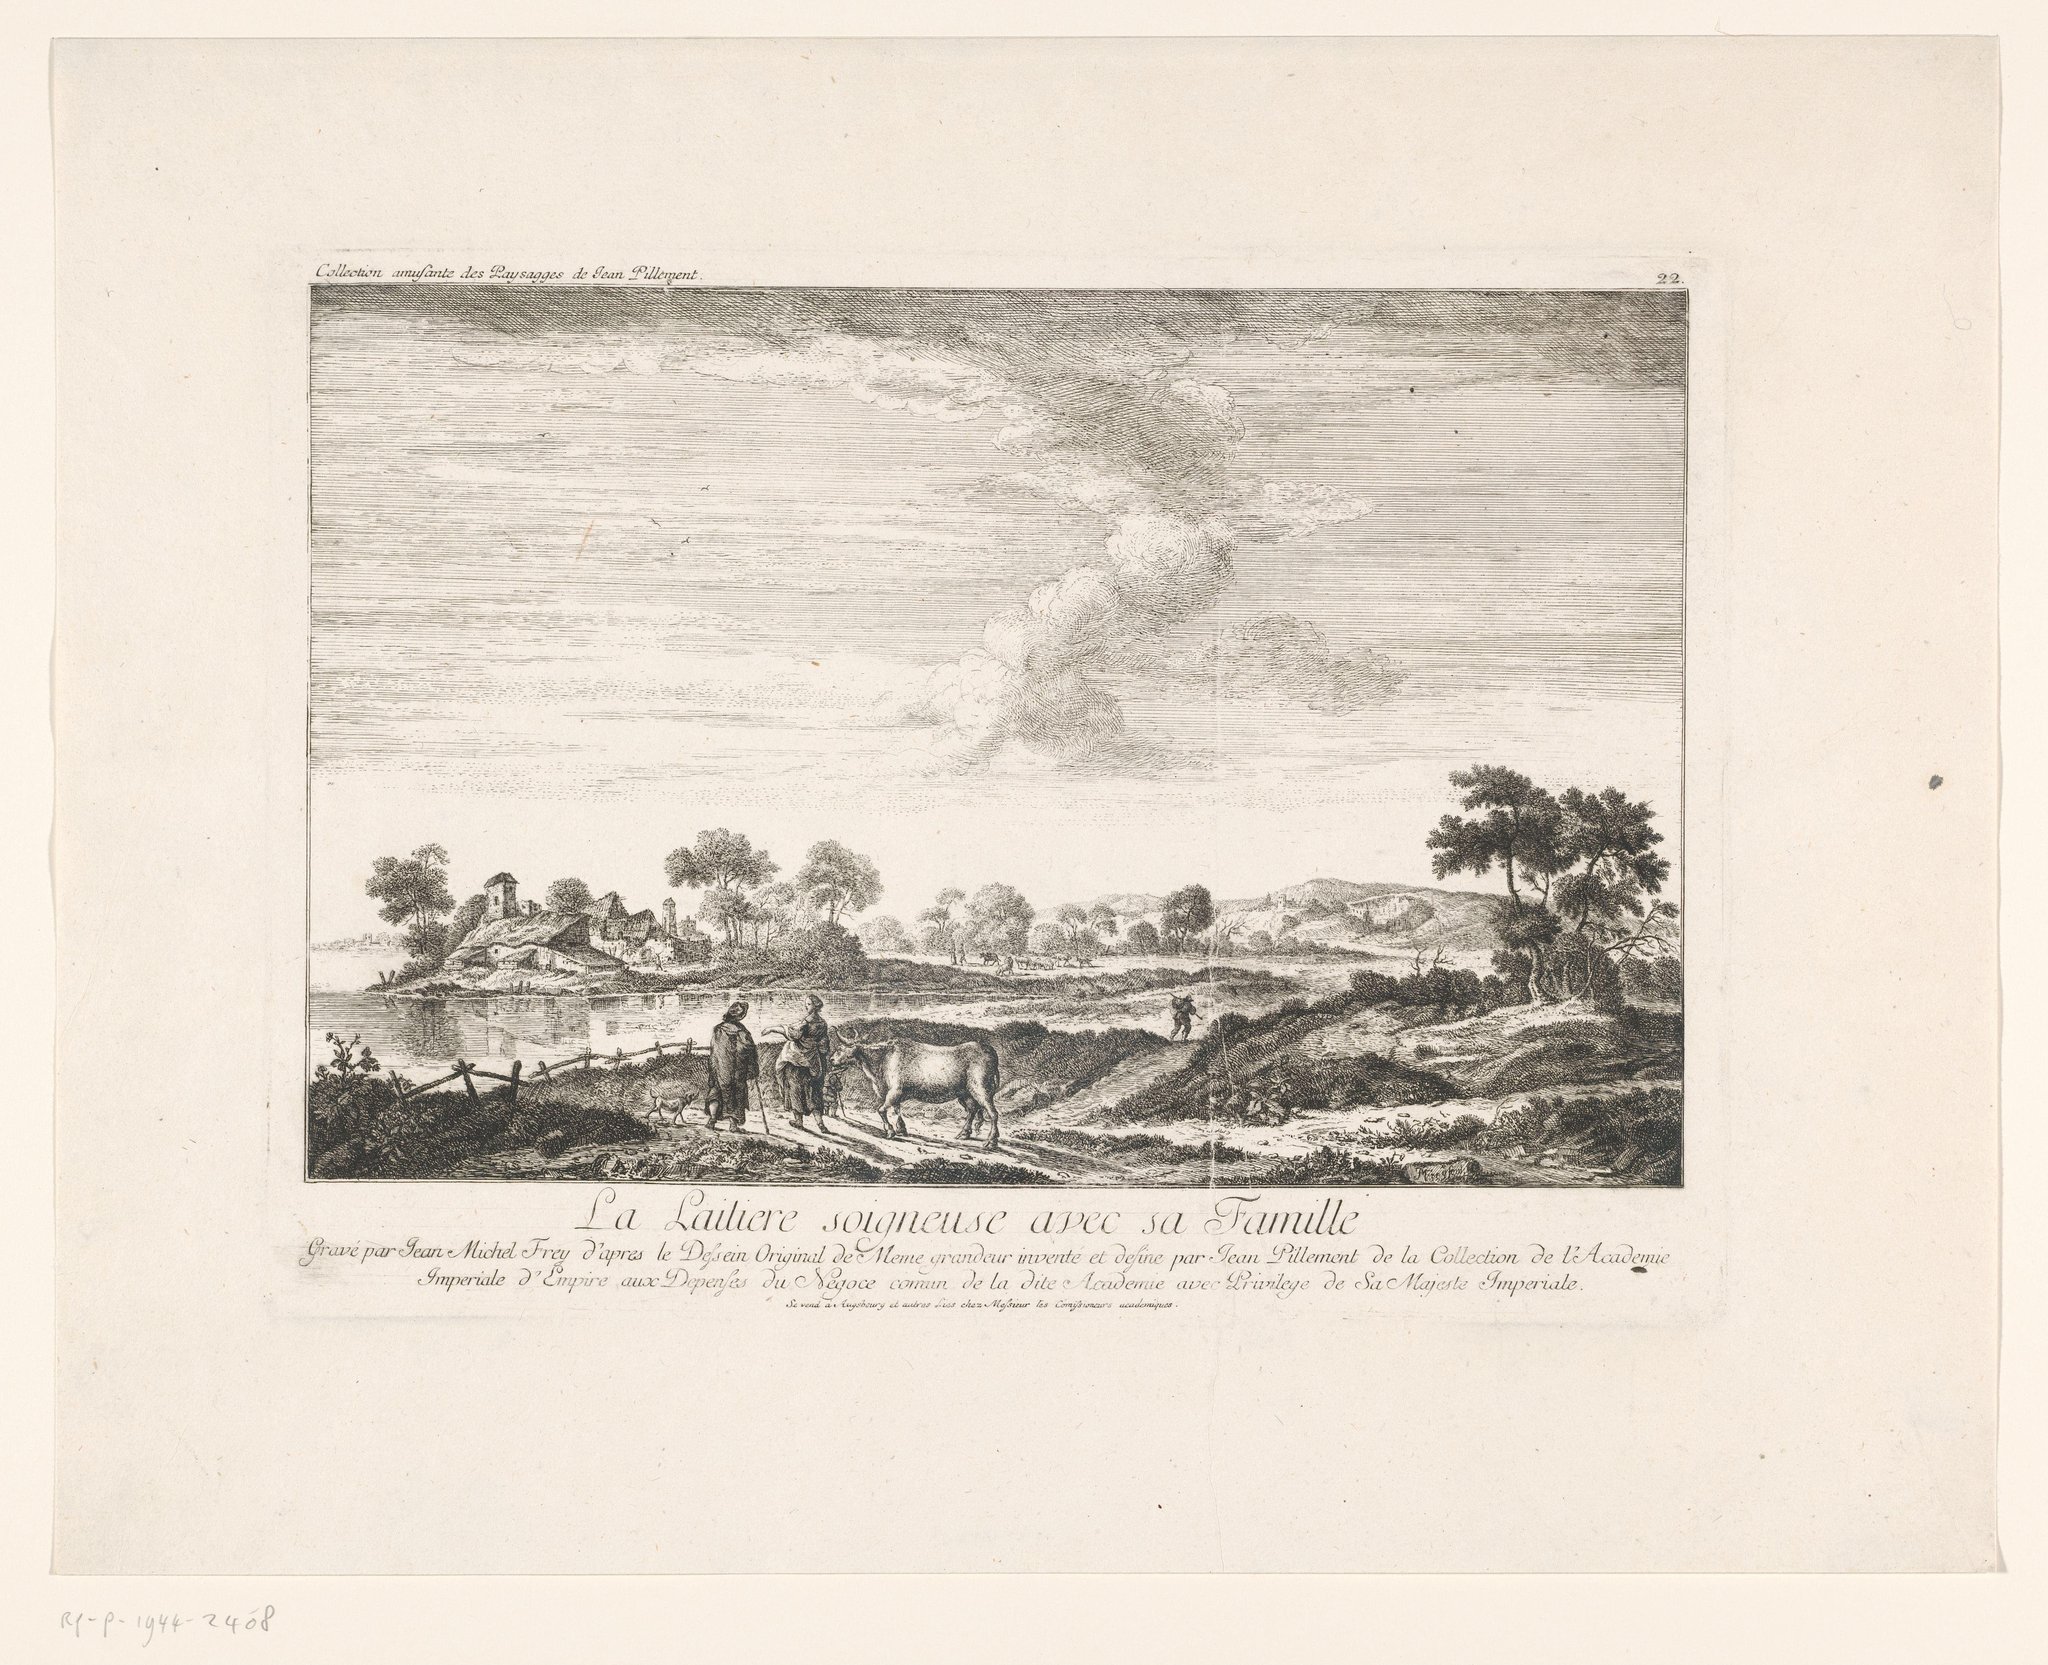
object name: print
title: Rivierlandschap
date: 1760-1818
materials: paper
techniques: etching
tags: landscapes with waters, waterscapes, seascapes (in the temperate zone)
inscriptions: collector's mark: Lugt 2228